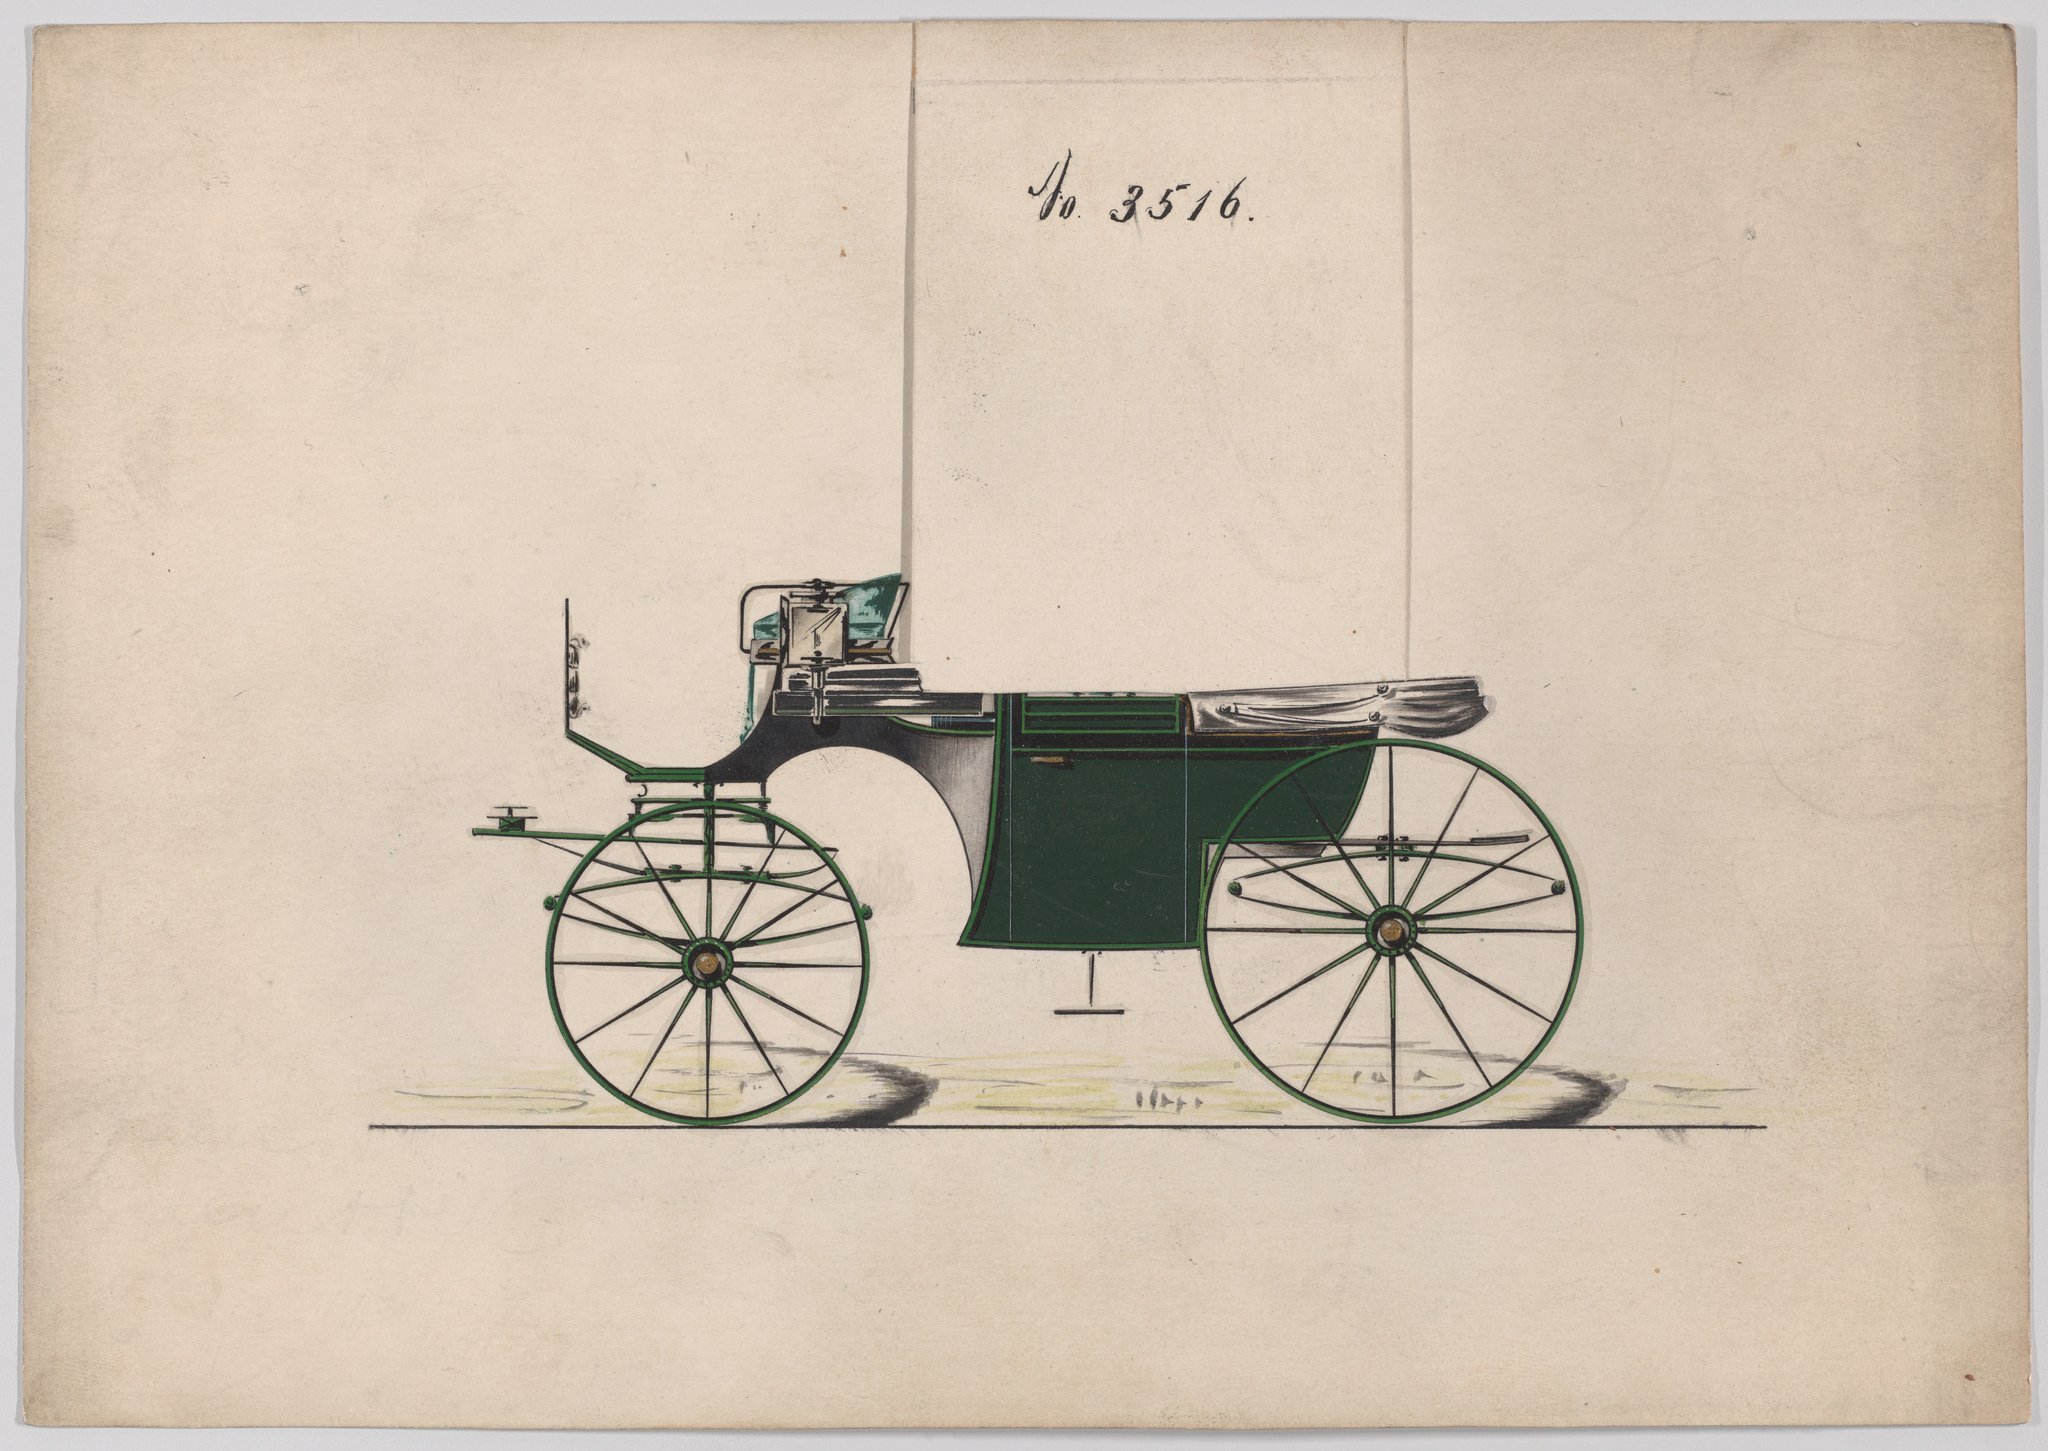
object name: drawing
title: Design for Landaulet, no. 3516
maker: brewster & co.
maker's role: manufacturer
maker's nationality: american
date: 1879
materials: gouache, gum arabic, ink, watercolor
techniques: pen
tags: carriages